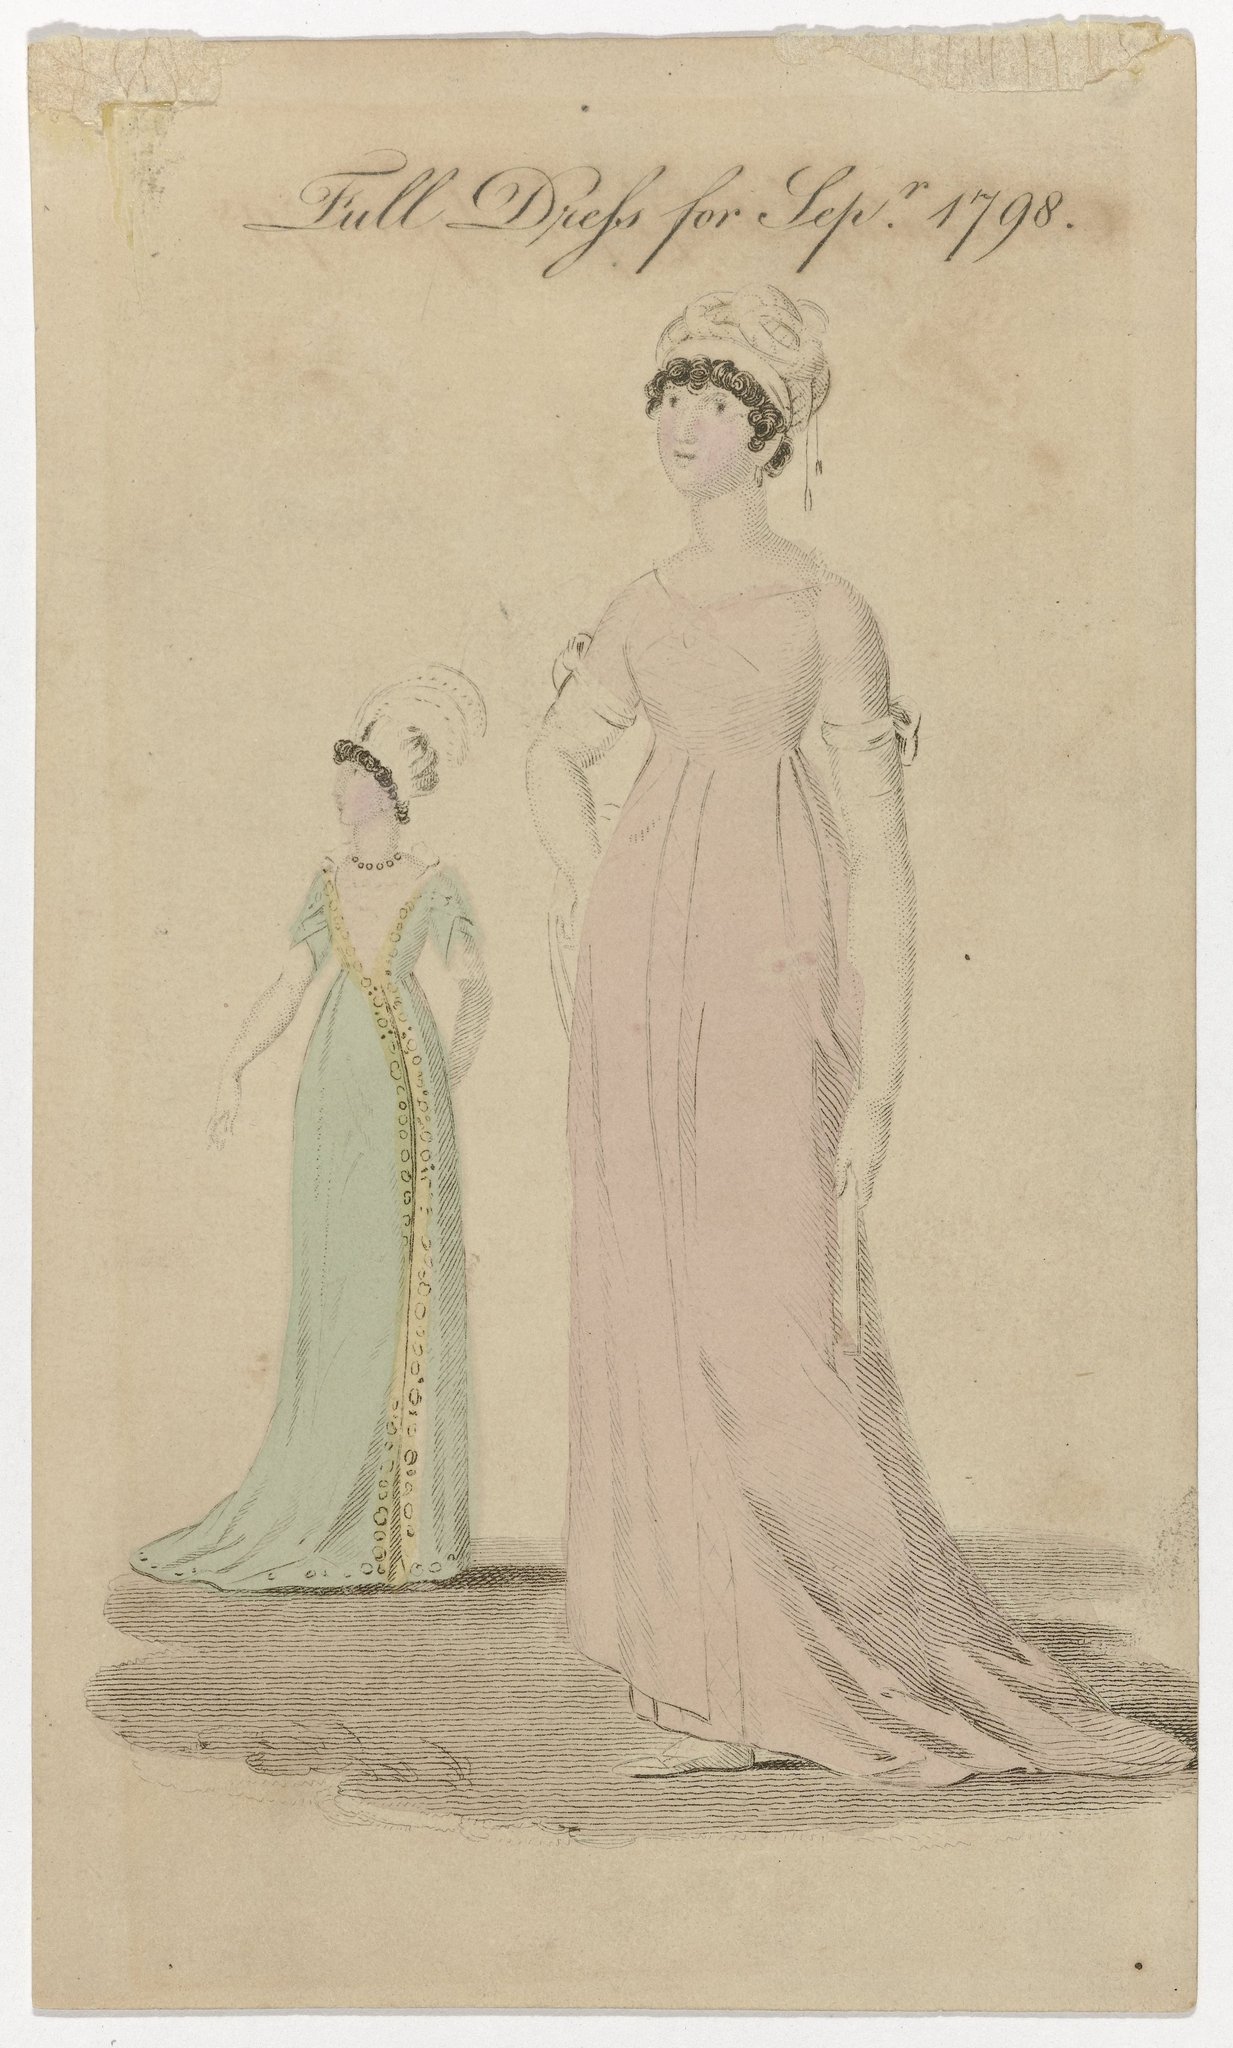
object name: fashion print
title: Ladies Monthly Museum, 1798 : Full Dress for Sep.r 1798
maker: Anonymous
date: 1798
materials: paper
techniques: etching, hand coloring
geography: london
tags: head-gear: toque (+ women's clothes), dress, gown: evening dress (+ women's clothes), head-gear: turban (+ women's clothes), gloves, mittens (long gloves) (+ women's clothes), fashion plates, fan (+ women's clothes), necklace (+ women's clothes)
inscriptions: title: ‘Full Dress for Sep.r 1798.’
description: 'Full dress' of avondjaponnen met korte mouwen en sleep. Accessoires: toque en/of tulband(?), collier, lange handschoenen, waaier, schoen met puntige neus. Waarschijnlijk uit het modetijdschrift 'Ladies Monthly Museum', Londen, 1798-1832.